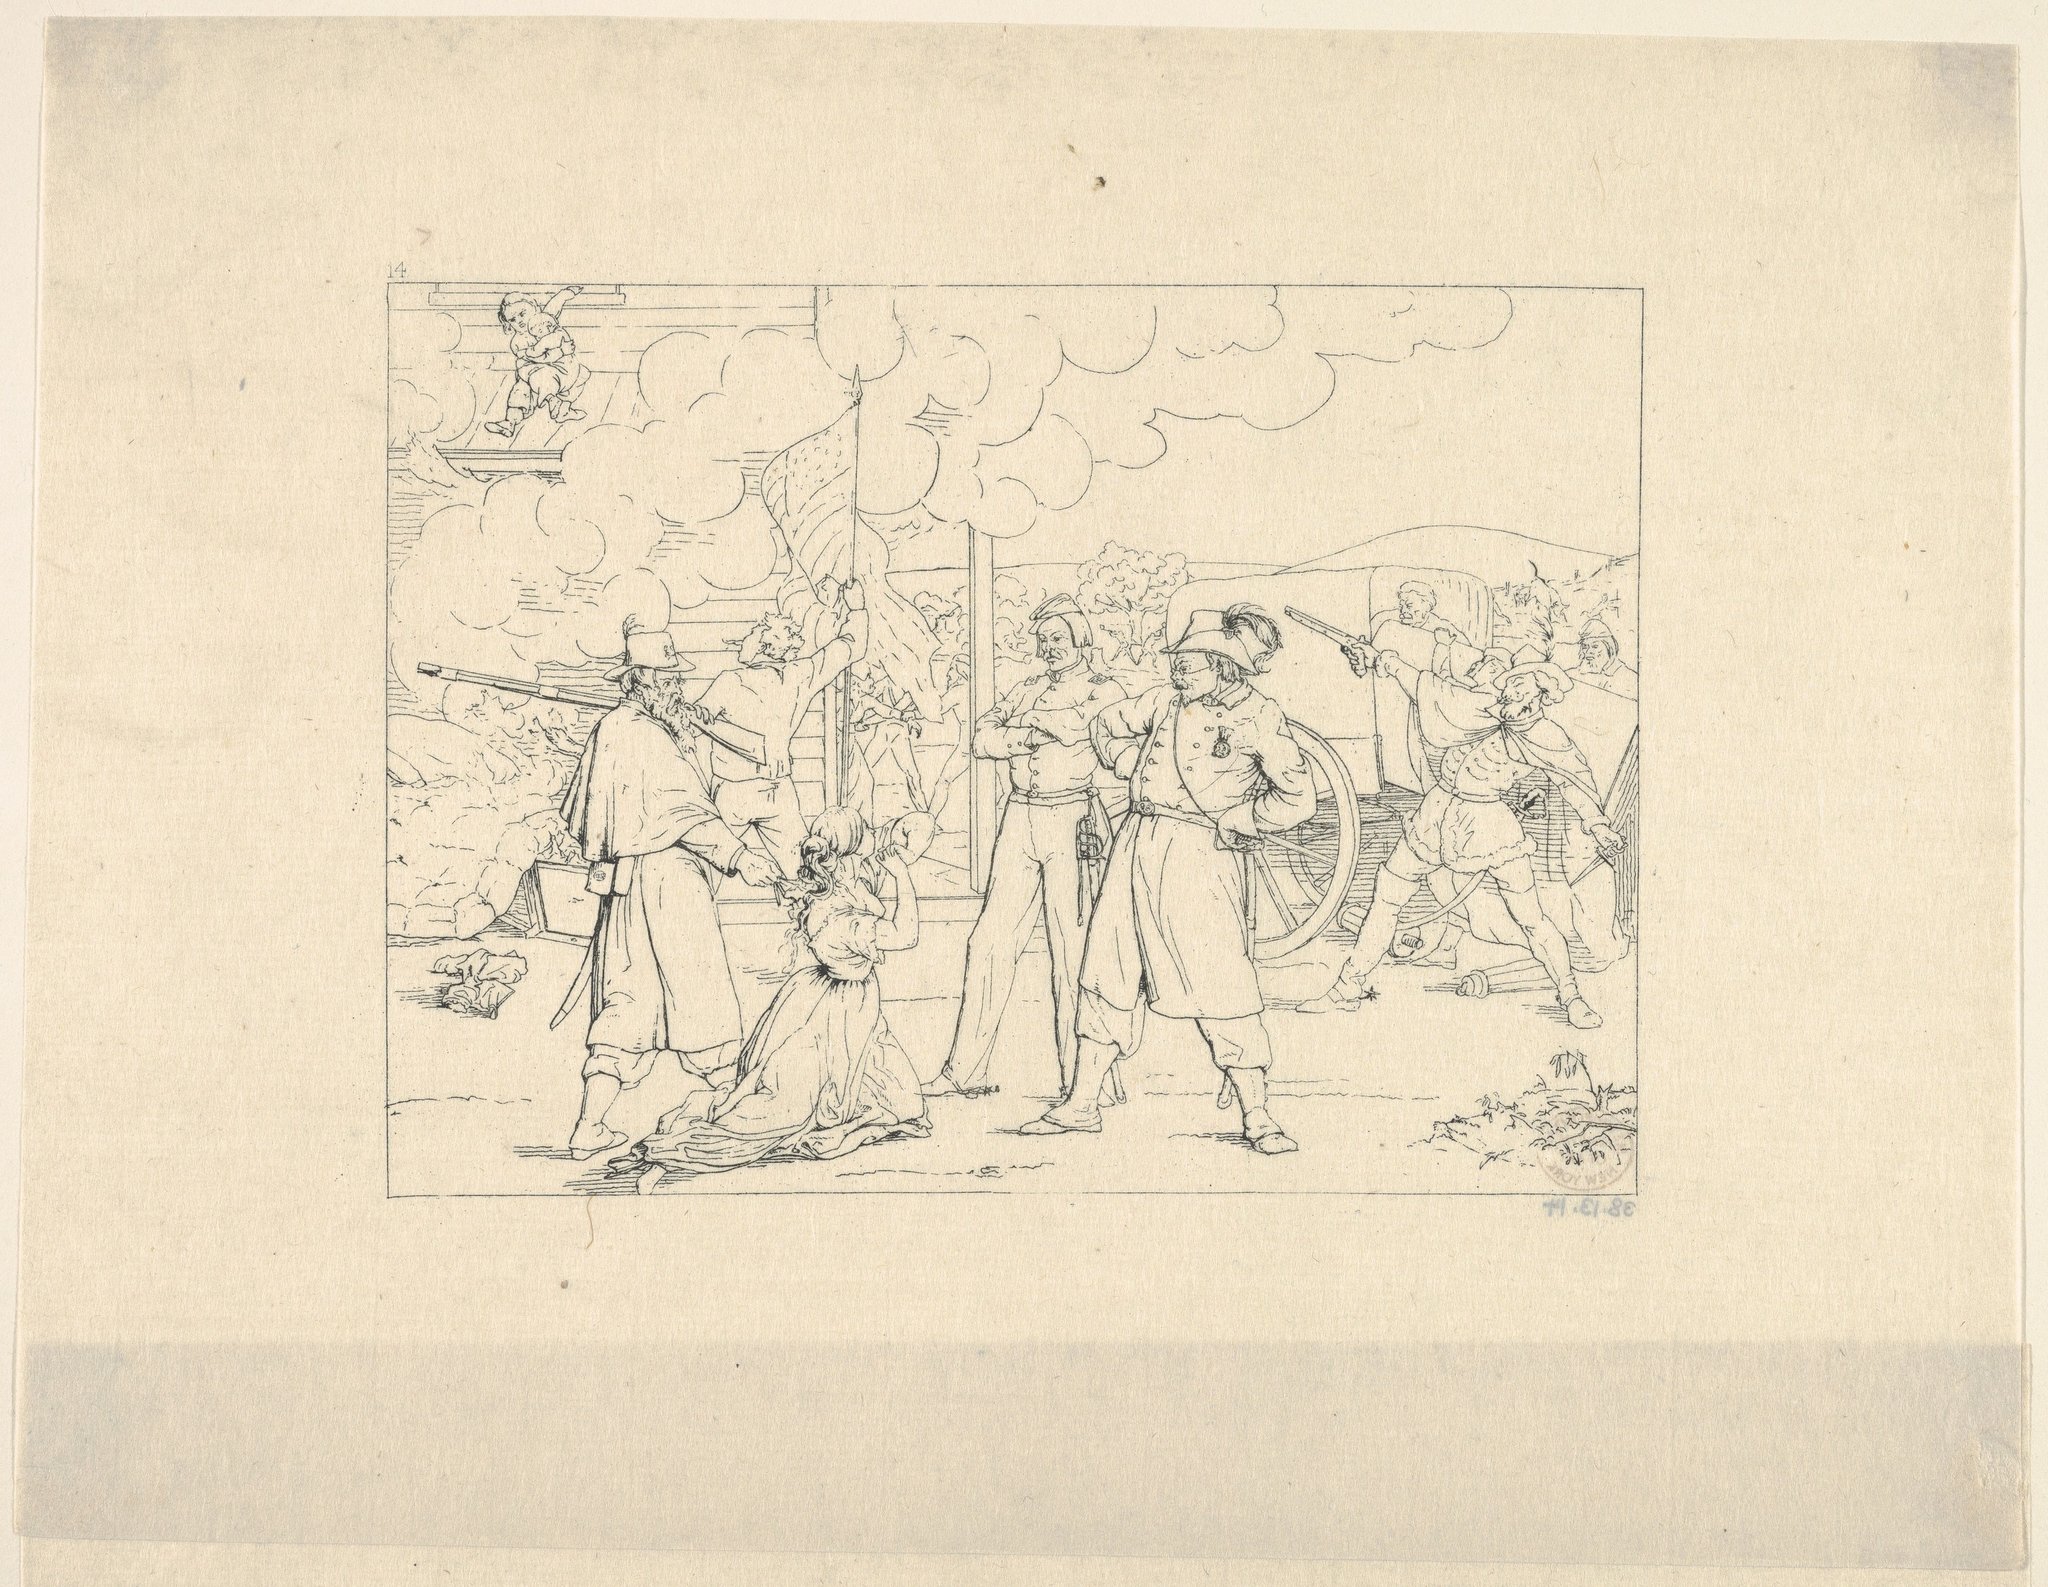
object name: print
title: Valiant Men "Dat Fite Mit Siegel" (from Confederate War Etchings)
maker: adalbert john volck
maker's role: artist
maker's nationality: american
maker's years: 1828-1912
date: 1861-1863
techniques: etching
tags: soldiers,firearms,american civil war,men,women